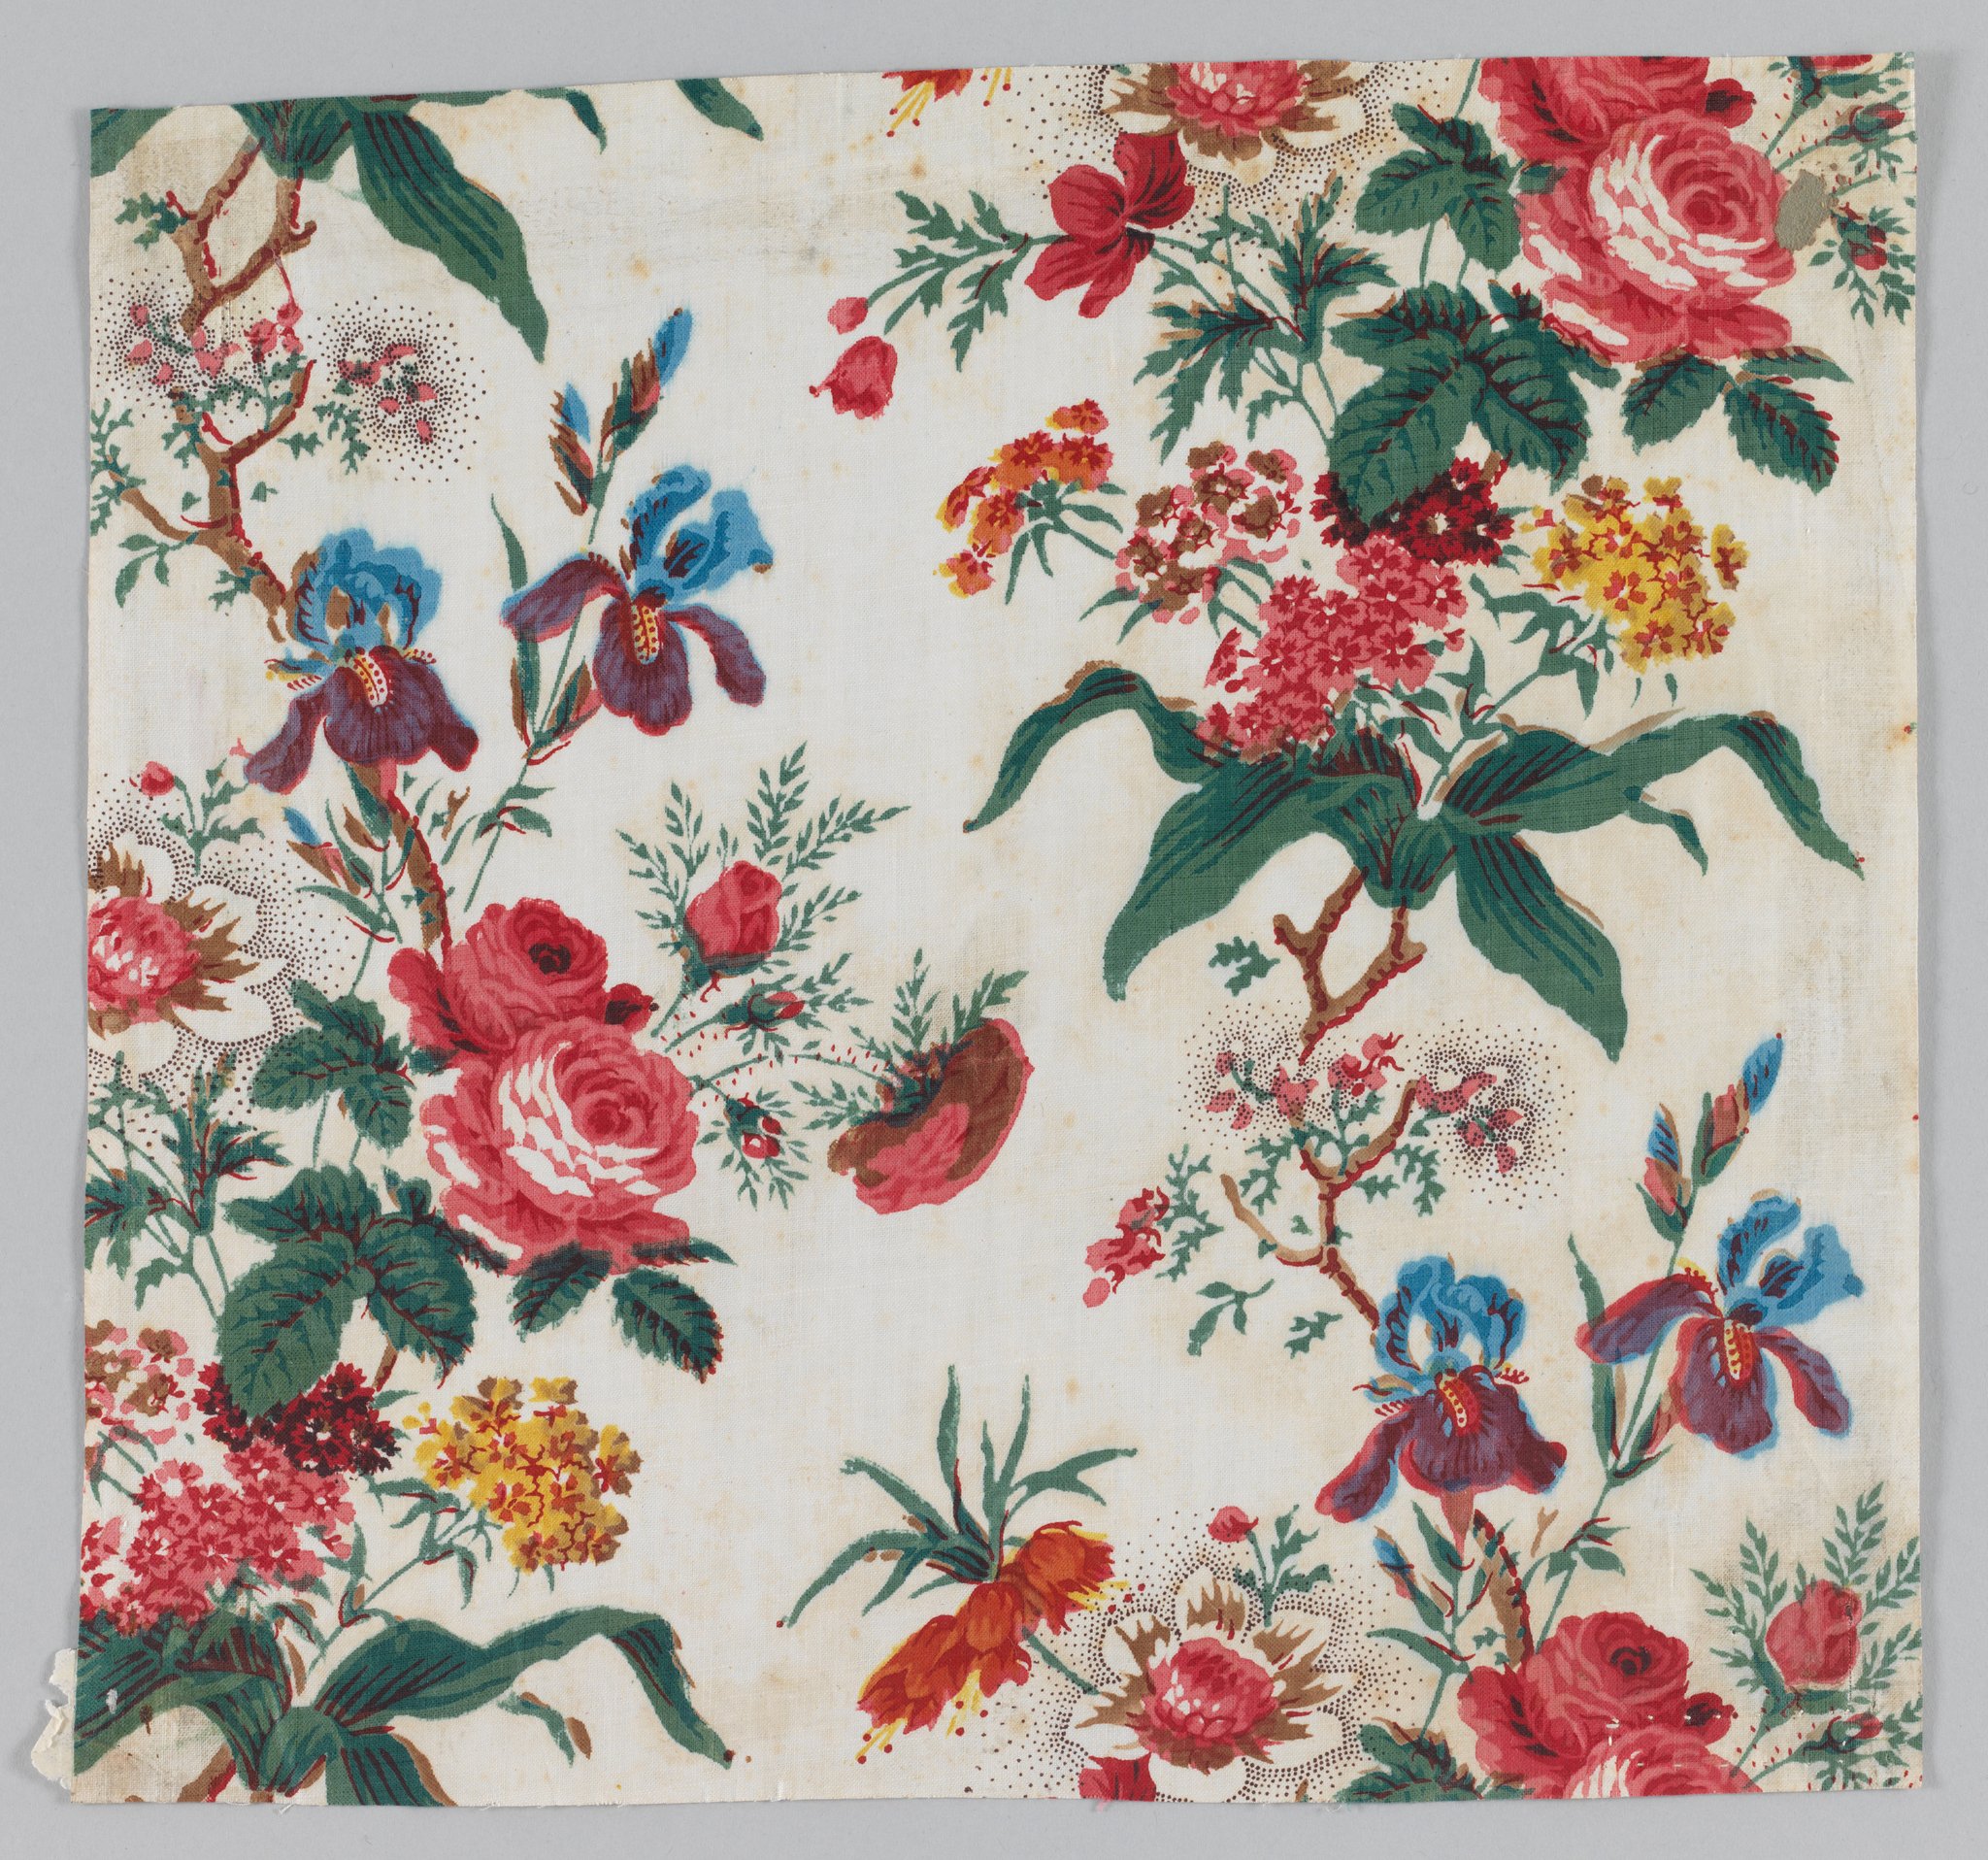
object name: piece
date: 1801-1900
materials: cotton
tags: flowers